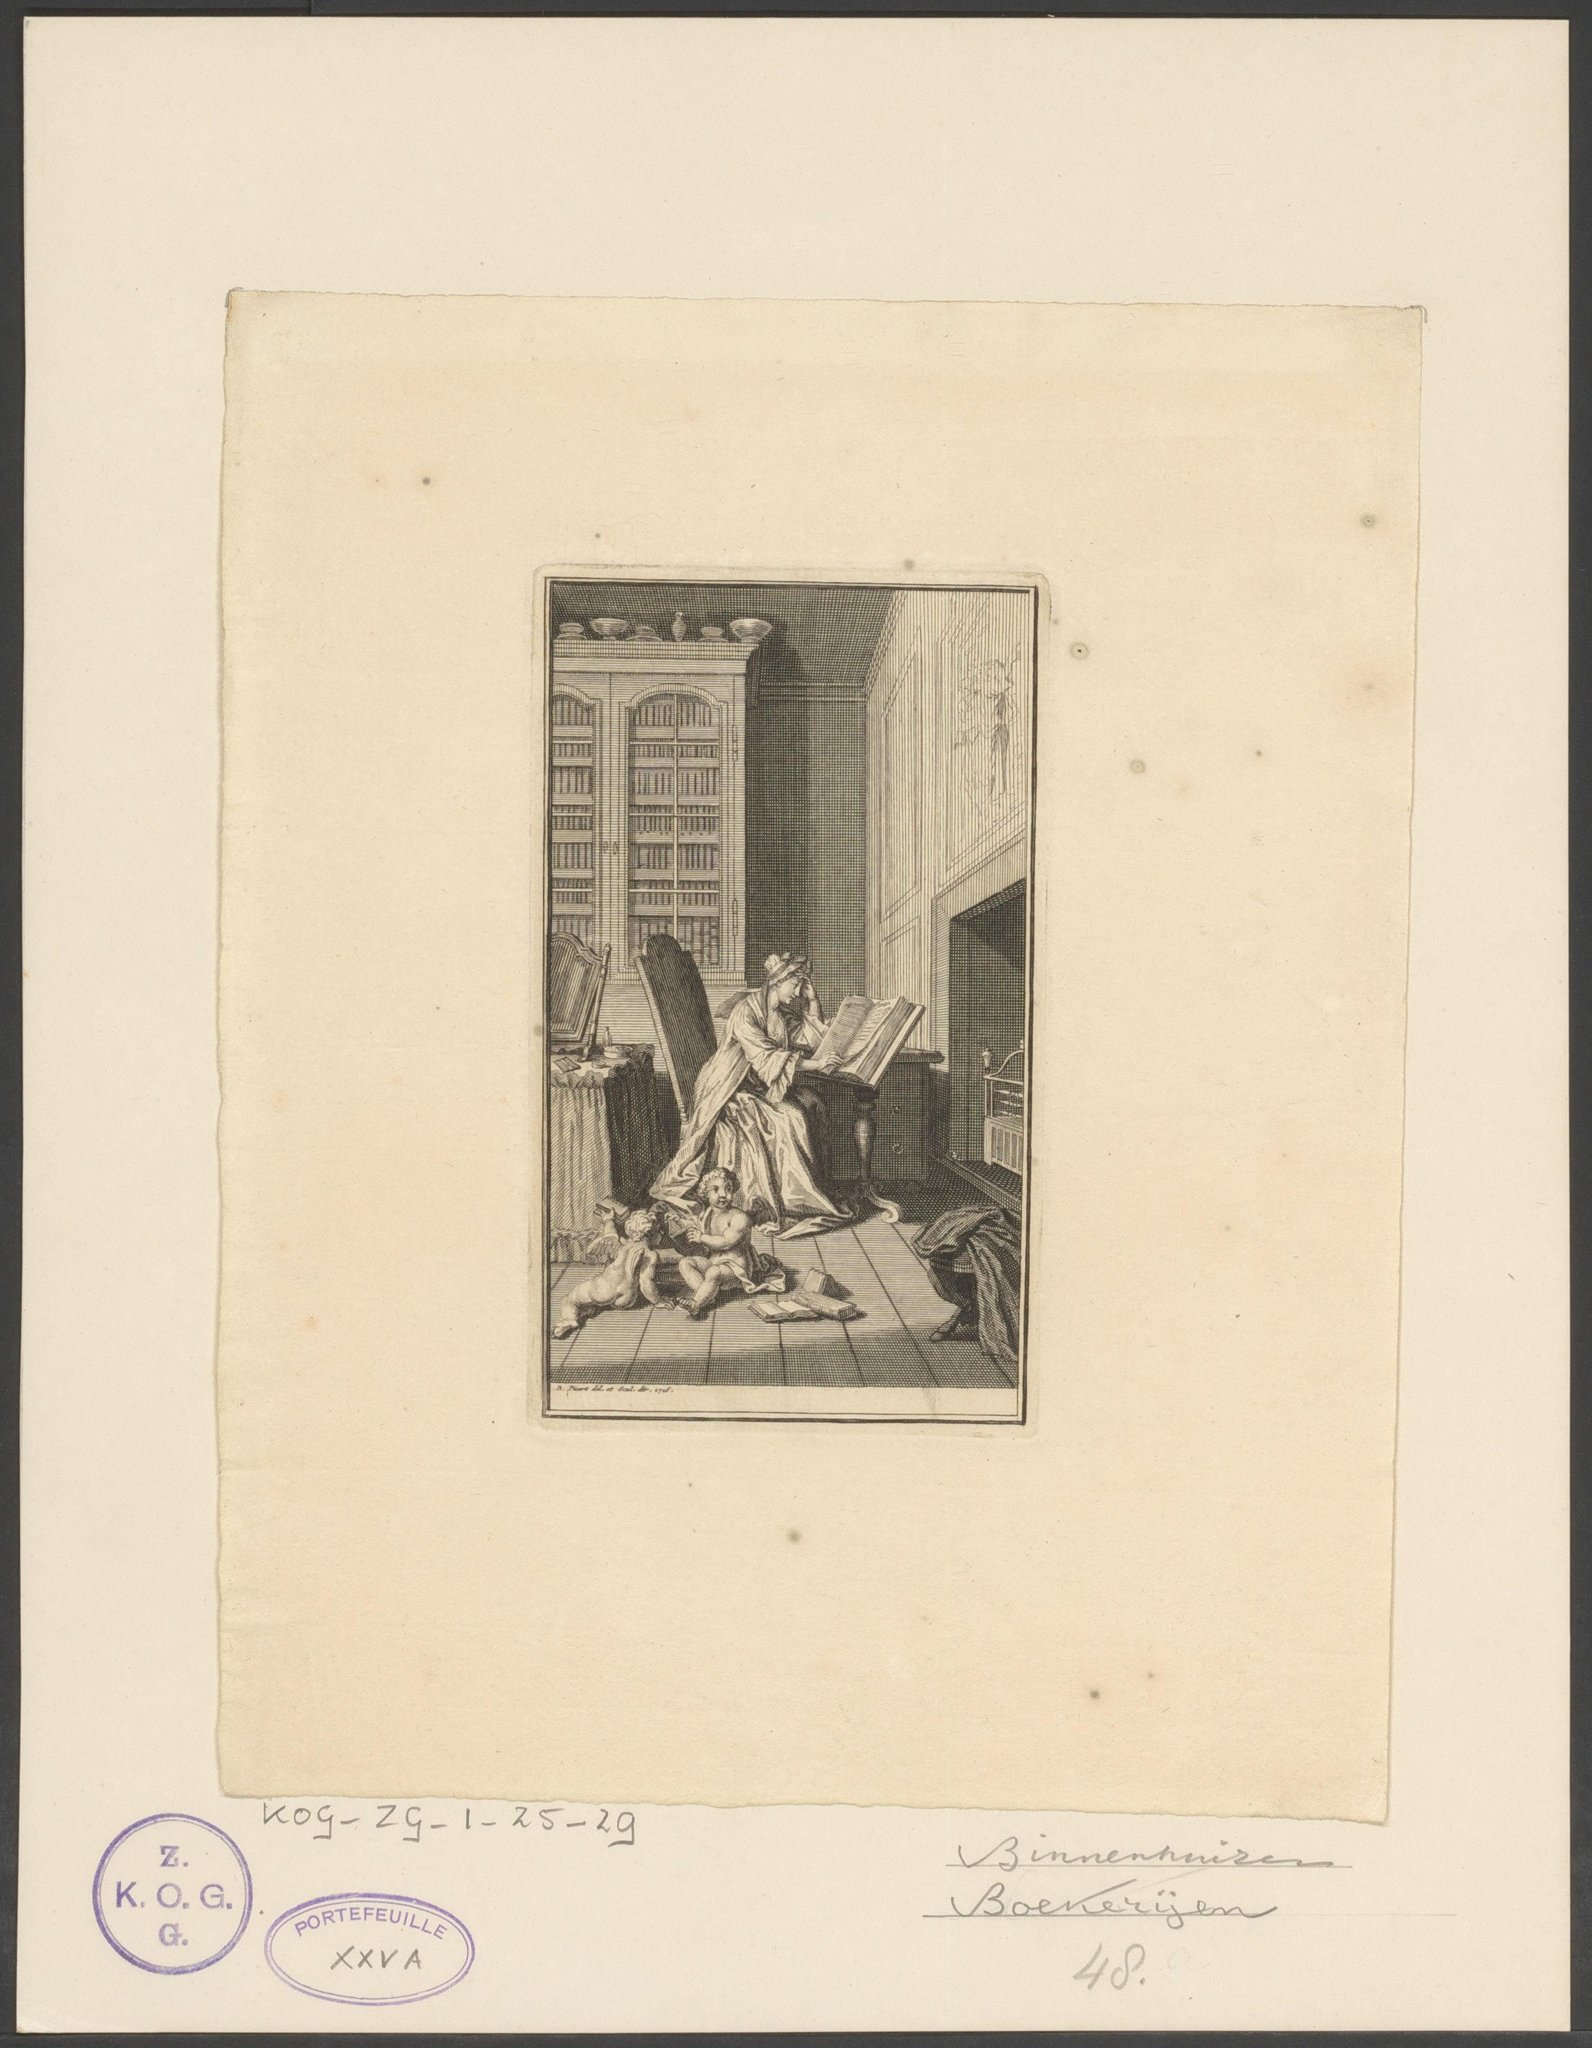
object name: print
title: Vrouw en twee putti in een studeerkamer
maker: bernard picart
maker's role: draughtsman, print maker, publisher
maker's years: 1673-1733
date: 1716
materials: paper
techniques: engraving, etching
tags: sitting figure - aa - female human figure, book, cupids: 'amores', 'amoretti', 'putti'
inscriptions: collector's mark: Lugt 1641, stamp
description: Titelpagina voor: Steele, Richard. Bibliotheque des dames, contenant des règles générales pour leur conduite (...). Ecrite par une dame, deel I. [Vertaald uit het Engels door] François Janiçon. Amsterdam: Emanuel Du Villard, 1719.